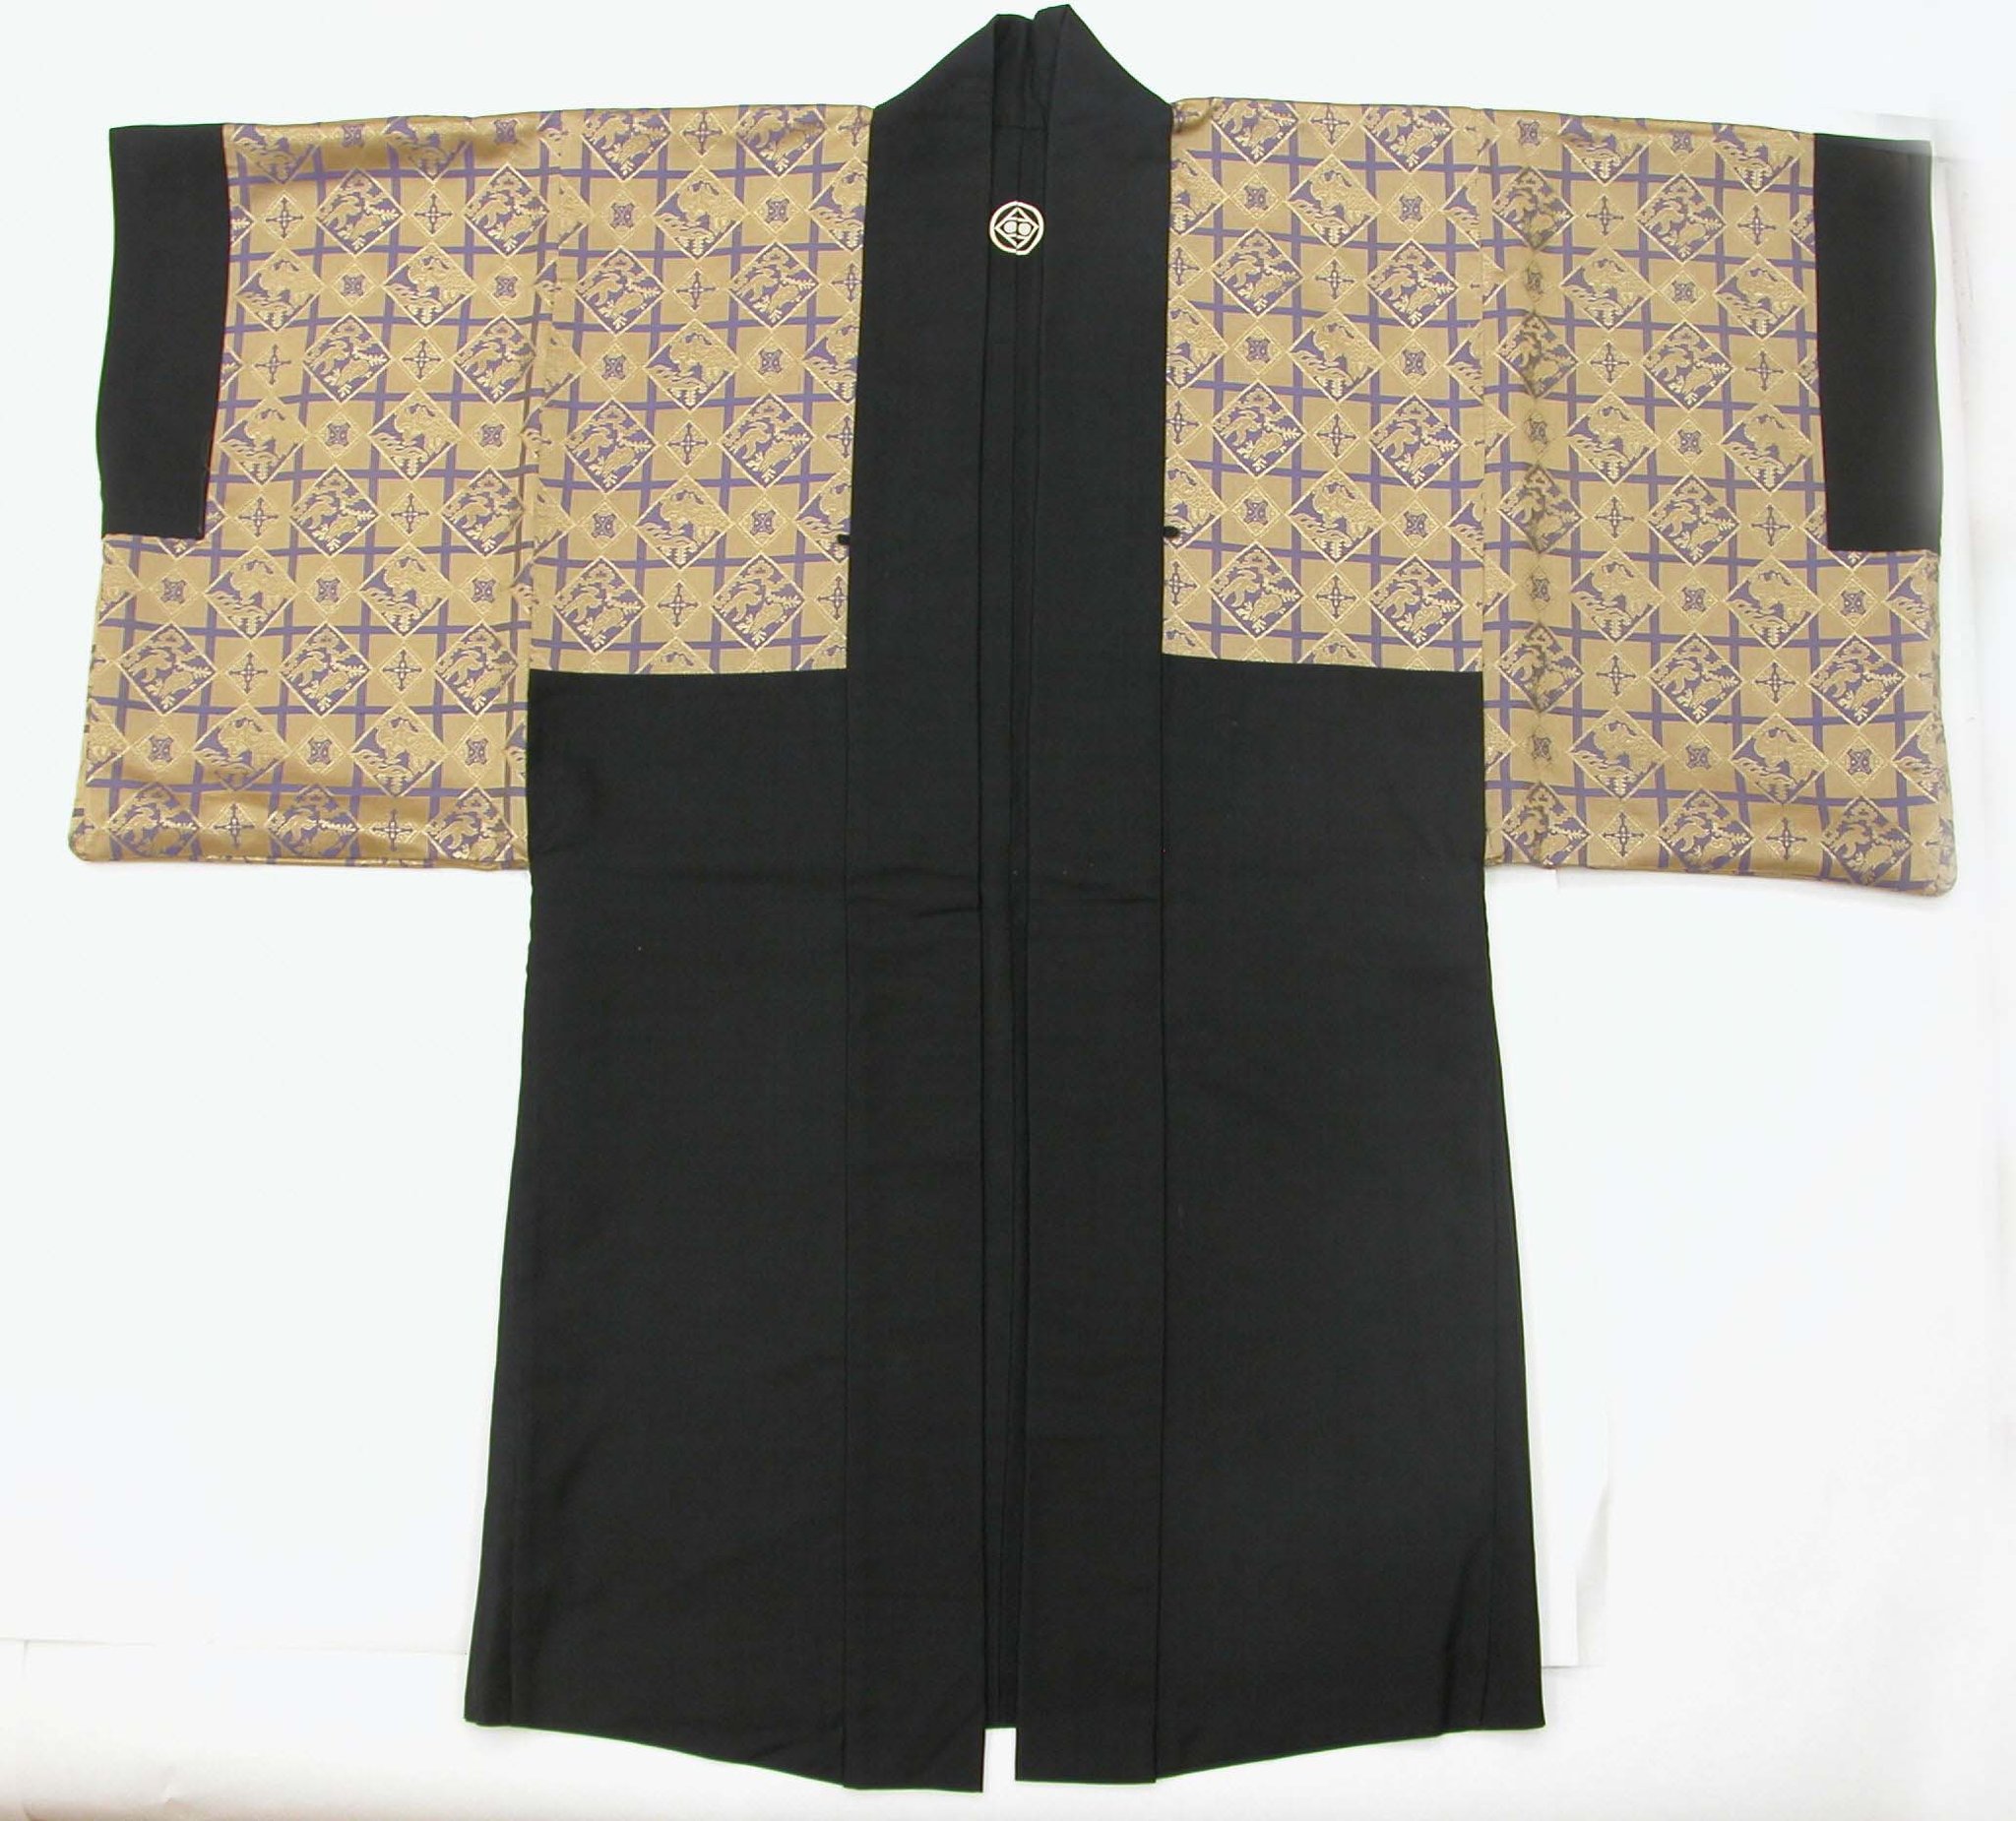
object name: costume, gentleman's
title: Costume of a Japanese Gentleman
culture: japanese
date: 1801-1900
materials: cotton, leather, silk, fiber, thread, wood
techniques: weave